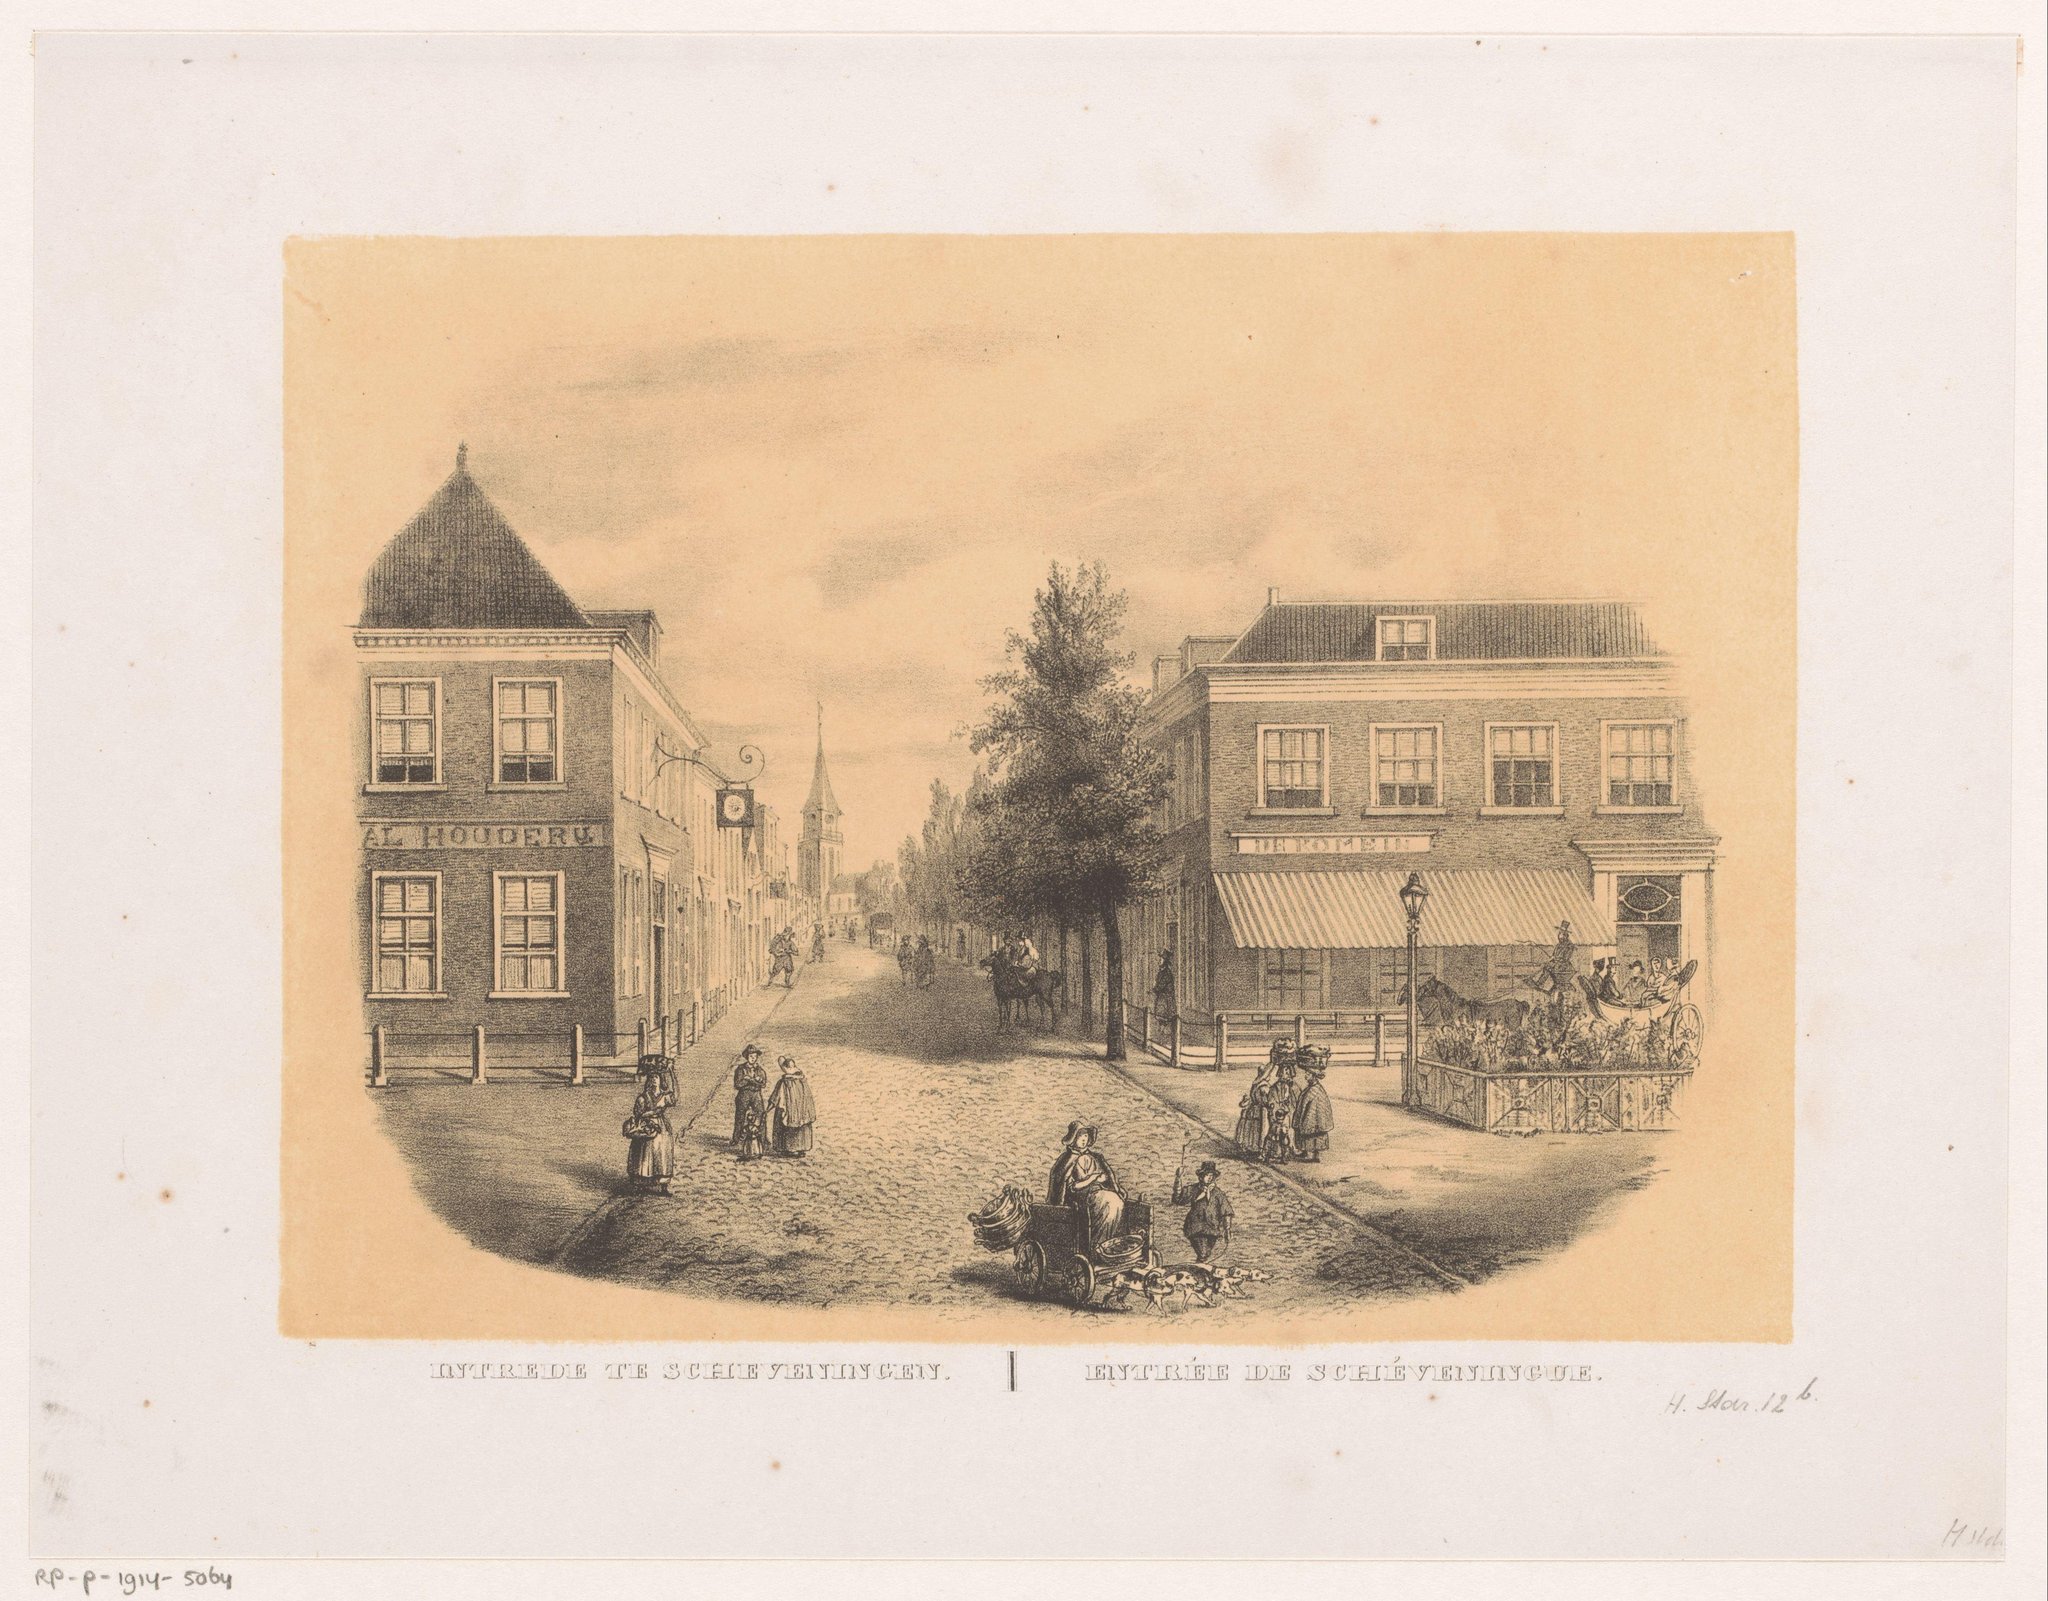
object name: print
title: Intrede te Scheveningen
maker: hendrik wilhelmus last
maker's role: print maker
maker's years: 1817-1873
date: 1827-1873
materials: paper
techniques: tone lithography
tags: street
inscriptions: collector's mark: Lugt 2228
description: Op straat lopen figuren. Rechts een rijtuig, in het midden een hondenkar. Aan het einde van de straat een kerktoren.